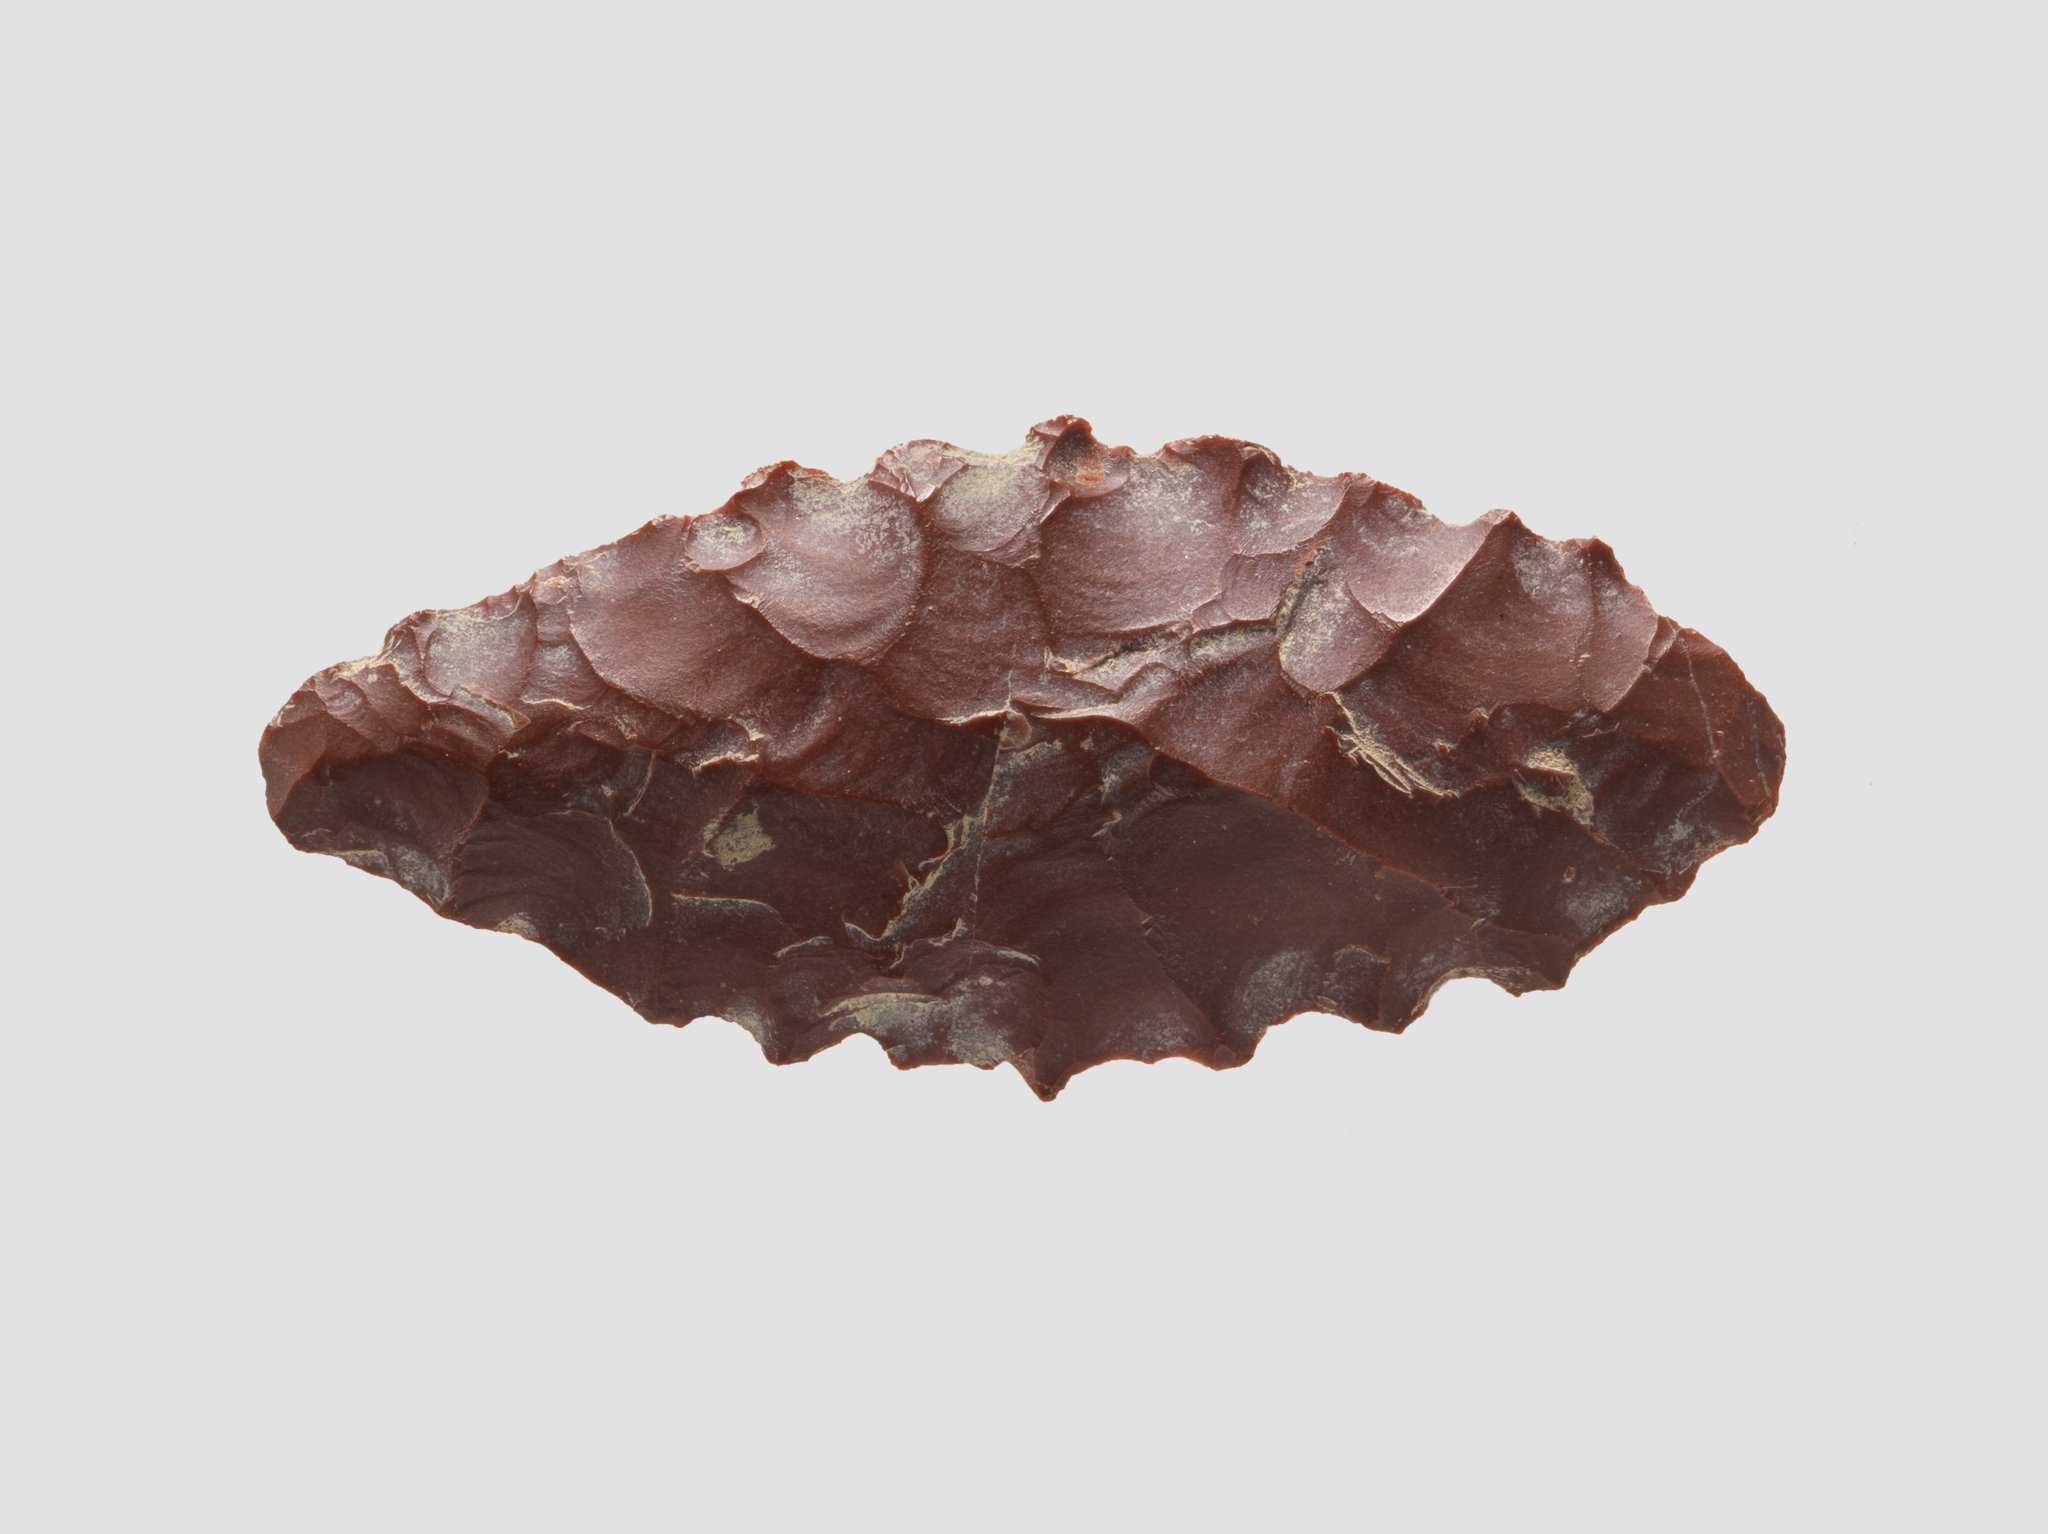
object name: tool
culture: iranian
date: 5000-2001 BCE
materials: stone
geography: iran